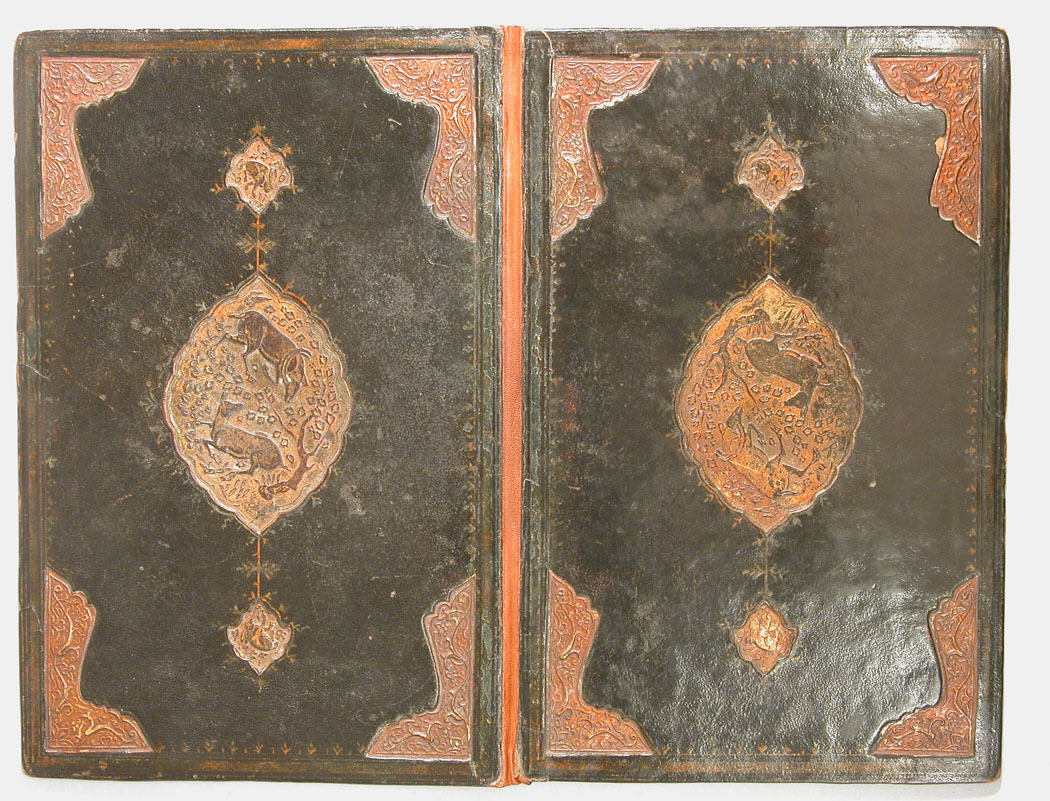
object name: bookbinding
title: Bookbinding (Jild-i kitab)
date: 1501-1533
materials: gold, leather, paper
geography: iran